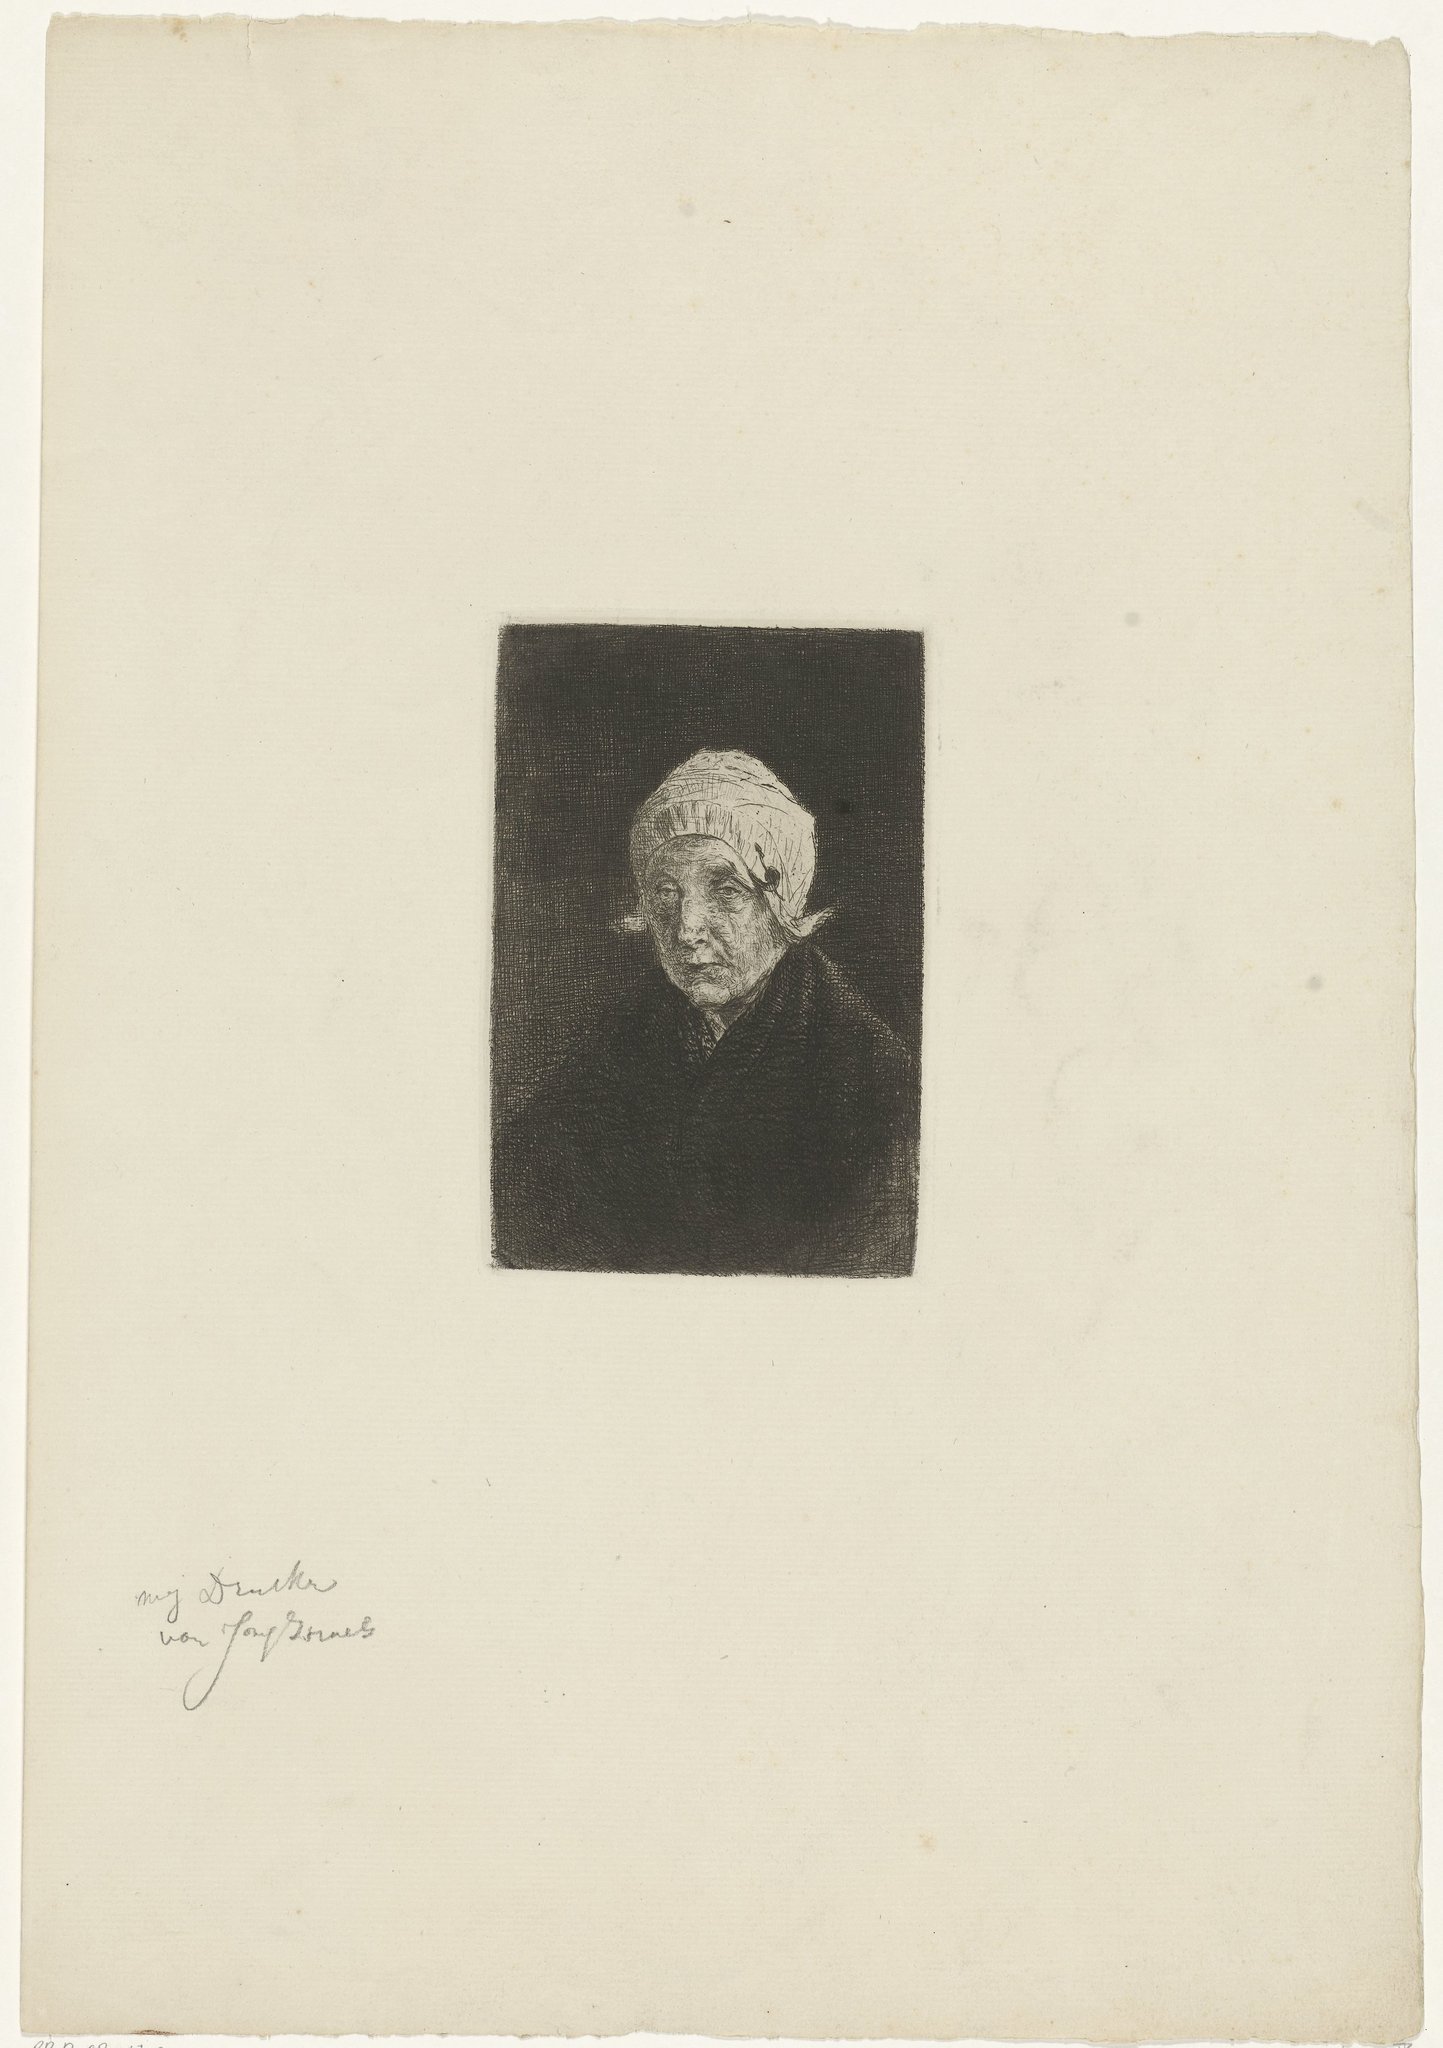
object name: print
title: Katwijkse oude vrouw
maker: jozef israëls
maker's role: draughtsman, painter, print maker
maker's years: 1824-1911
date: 1835-1911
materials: paper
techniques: etching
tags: old woman, chest, bust - aa - female human figure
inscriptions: signature: ‘mej [...] van Jozef Israels’, collector's mark: Lugt 2228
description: Buste van een Katwijkse oude vrouw, licht naar links.